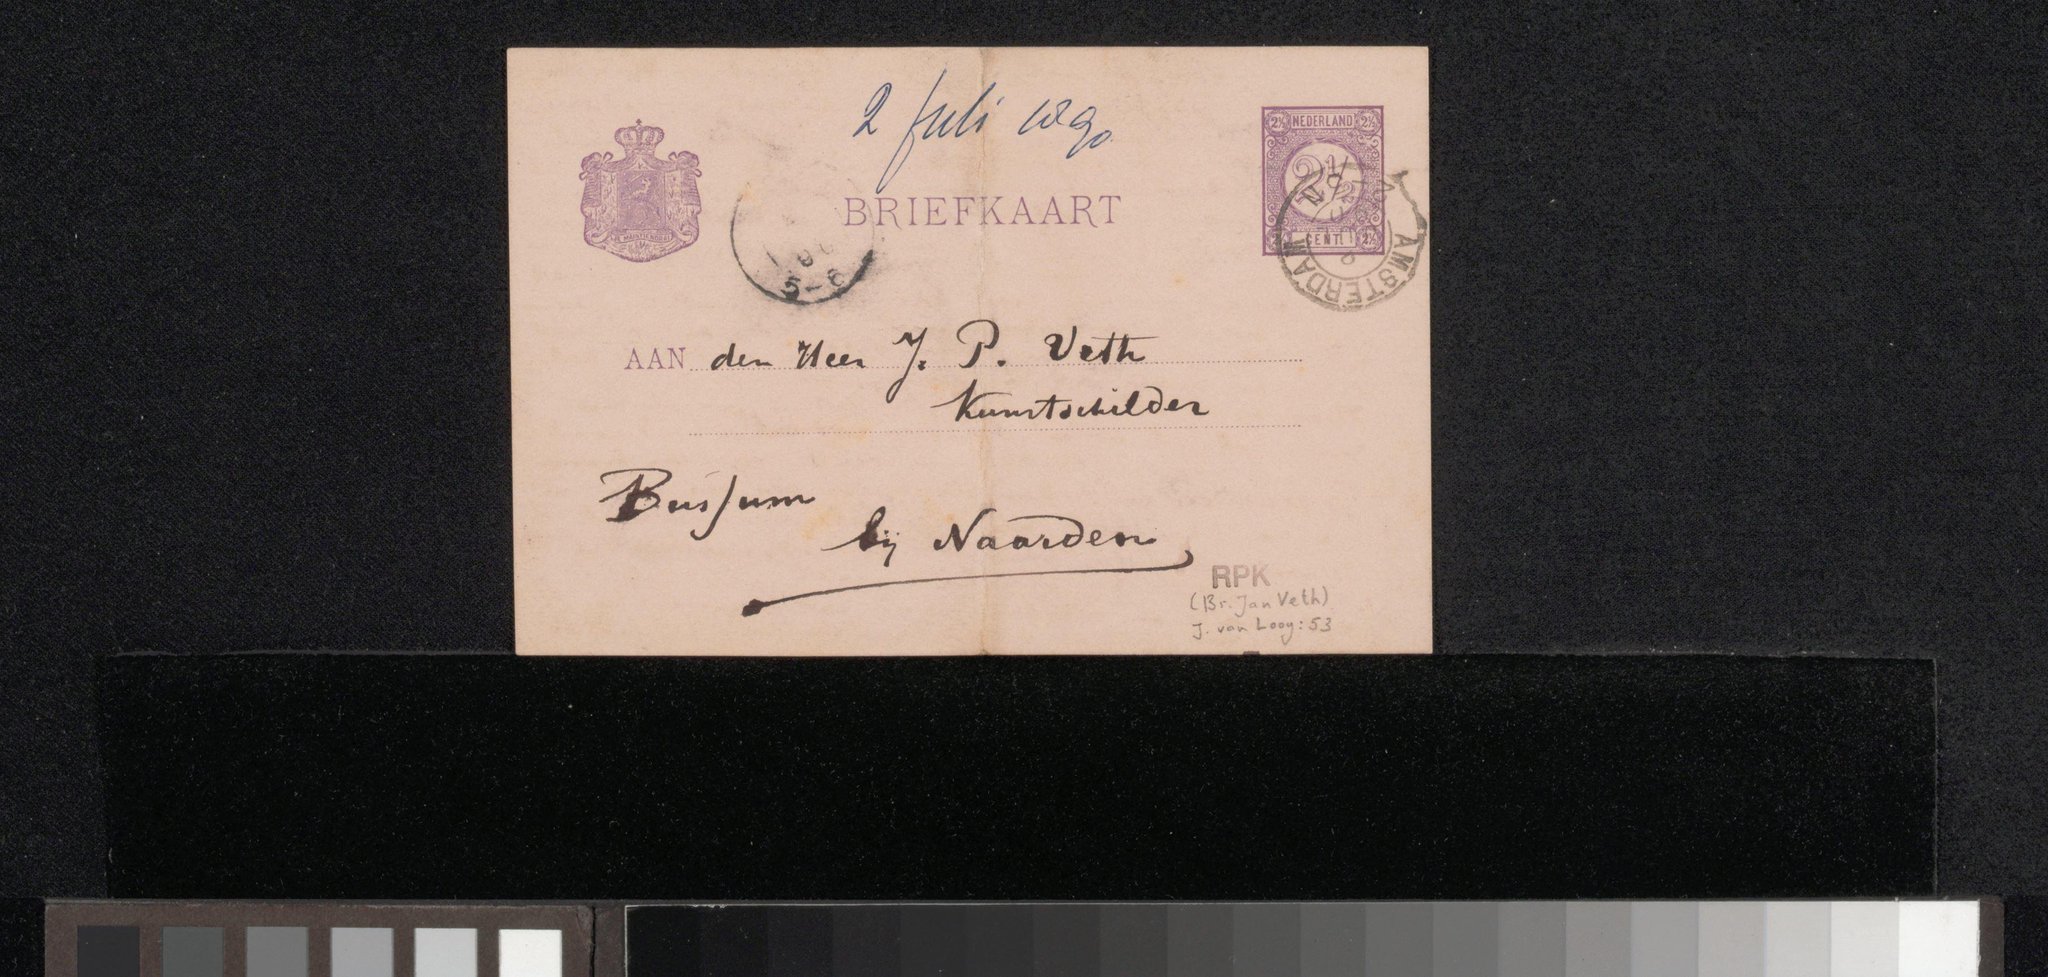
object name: postcard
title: Briefkaart aan Jan Veth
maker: jac van looij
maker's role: draughtsman, painter, print maker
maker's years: 1855-1930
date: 1807-1890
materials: cardboard, ink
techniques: pen, writing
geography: amsterdam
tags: designer, jan veth, maurits van der valk, painter, print maker, draughtsman, willem witsen, willem kloos, drawing, the graphic arts, painting (including book-illumination, miniature-painting), exhibition ~ art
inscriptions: collector's mark: ‘RPK’